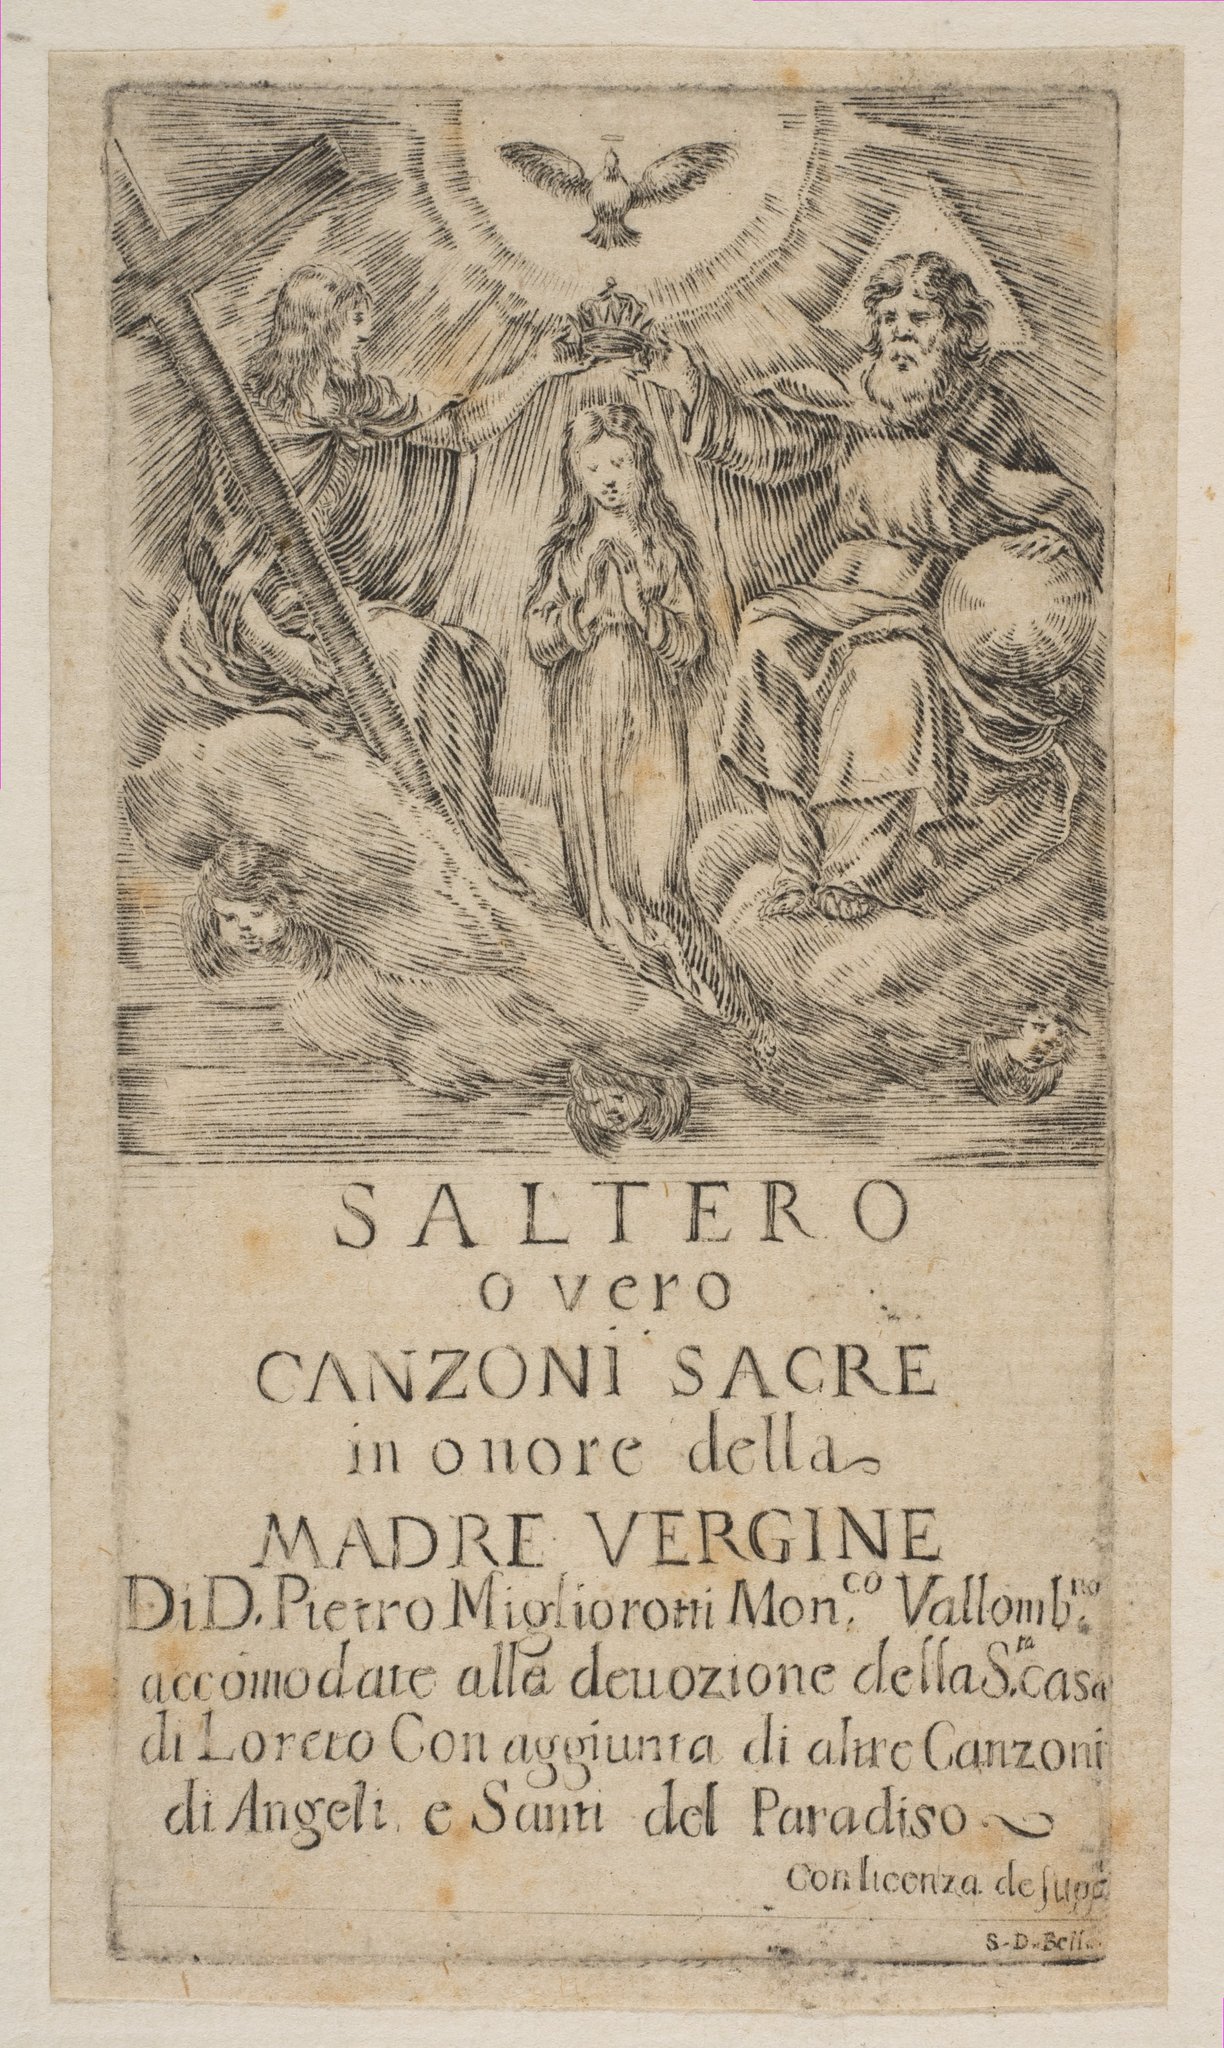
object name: print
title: Frontispiece for Saltero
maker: stefano della bella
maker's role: artist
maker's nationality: italian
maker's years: 1610-1664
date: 1633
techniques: etching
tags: birds,christ,cross,saints